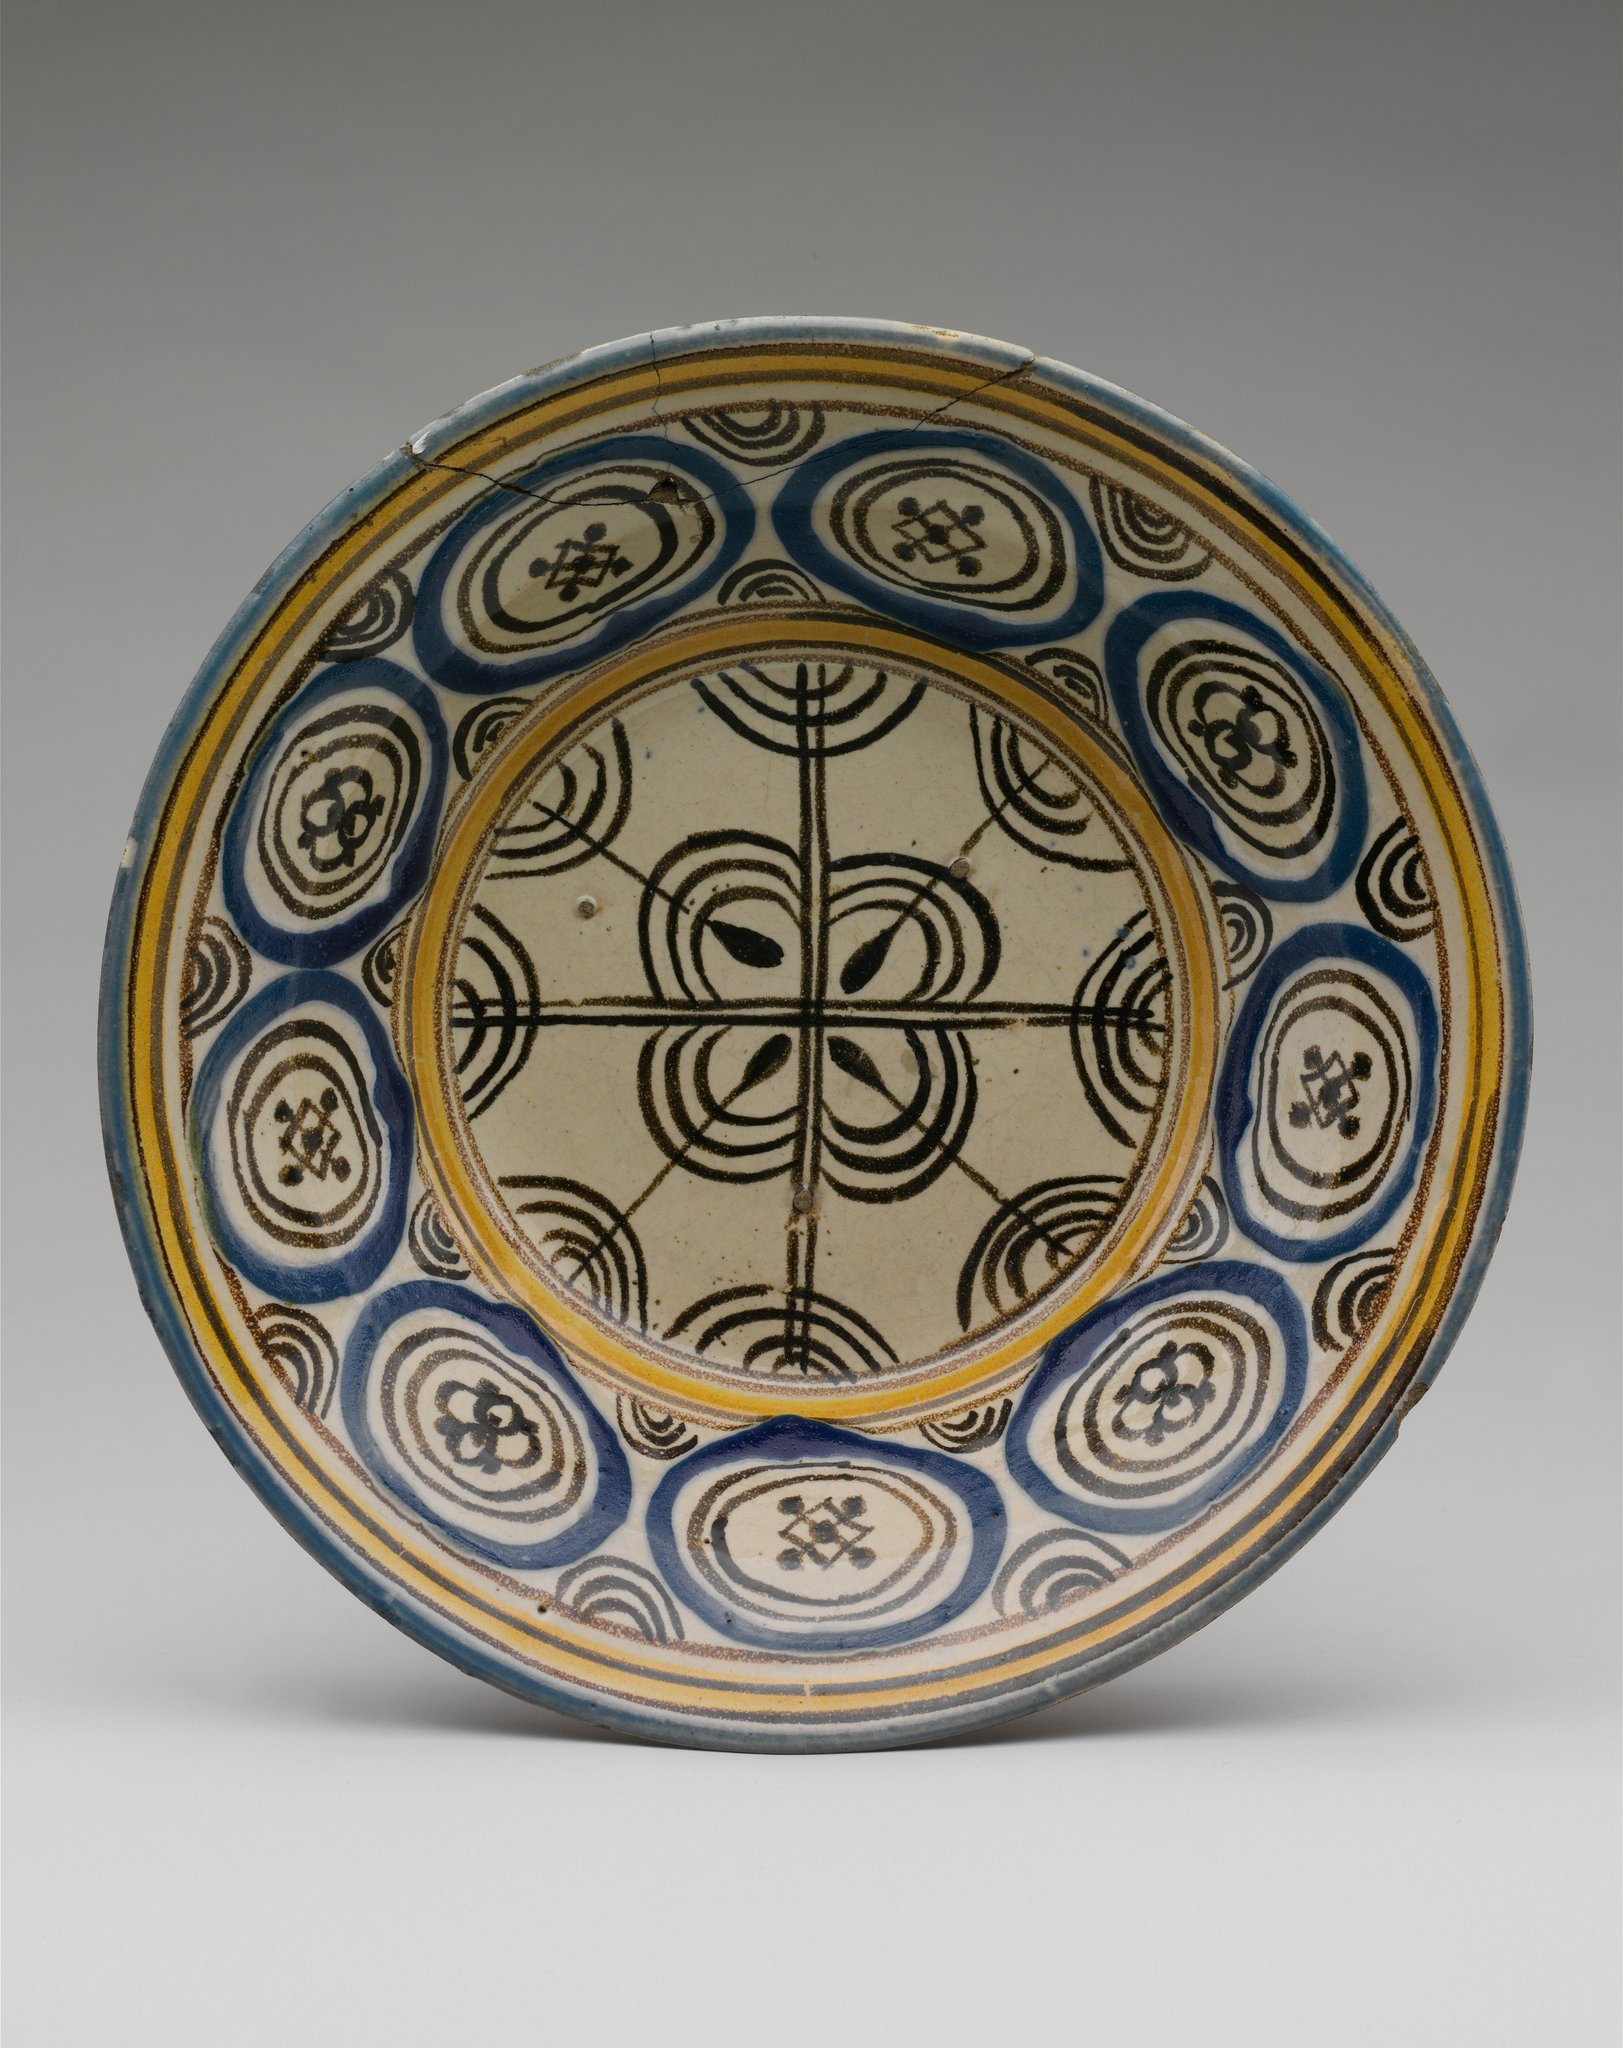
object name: bowl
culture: mexican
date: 1875-1900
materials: earthenware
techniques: glazing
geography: mexico